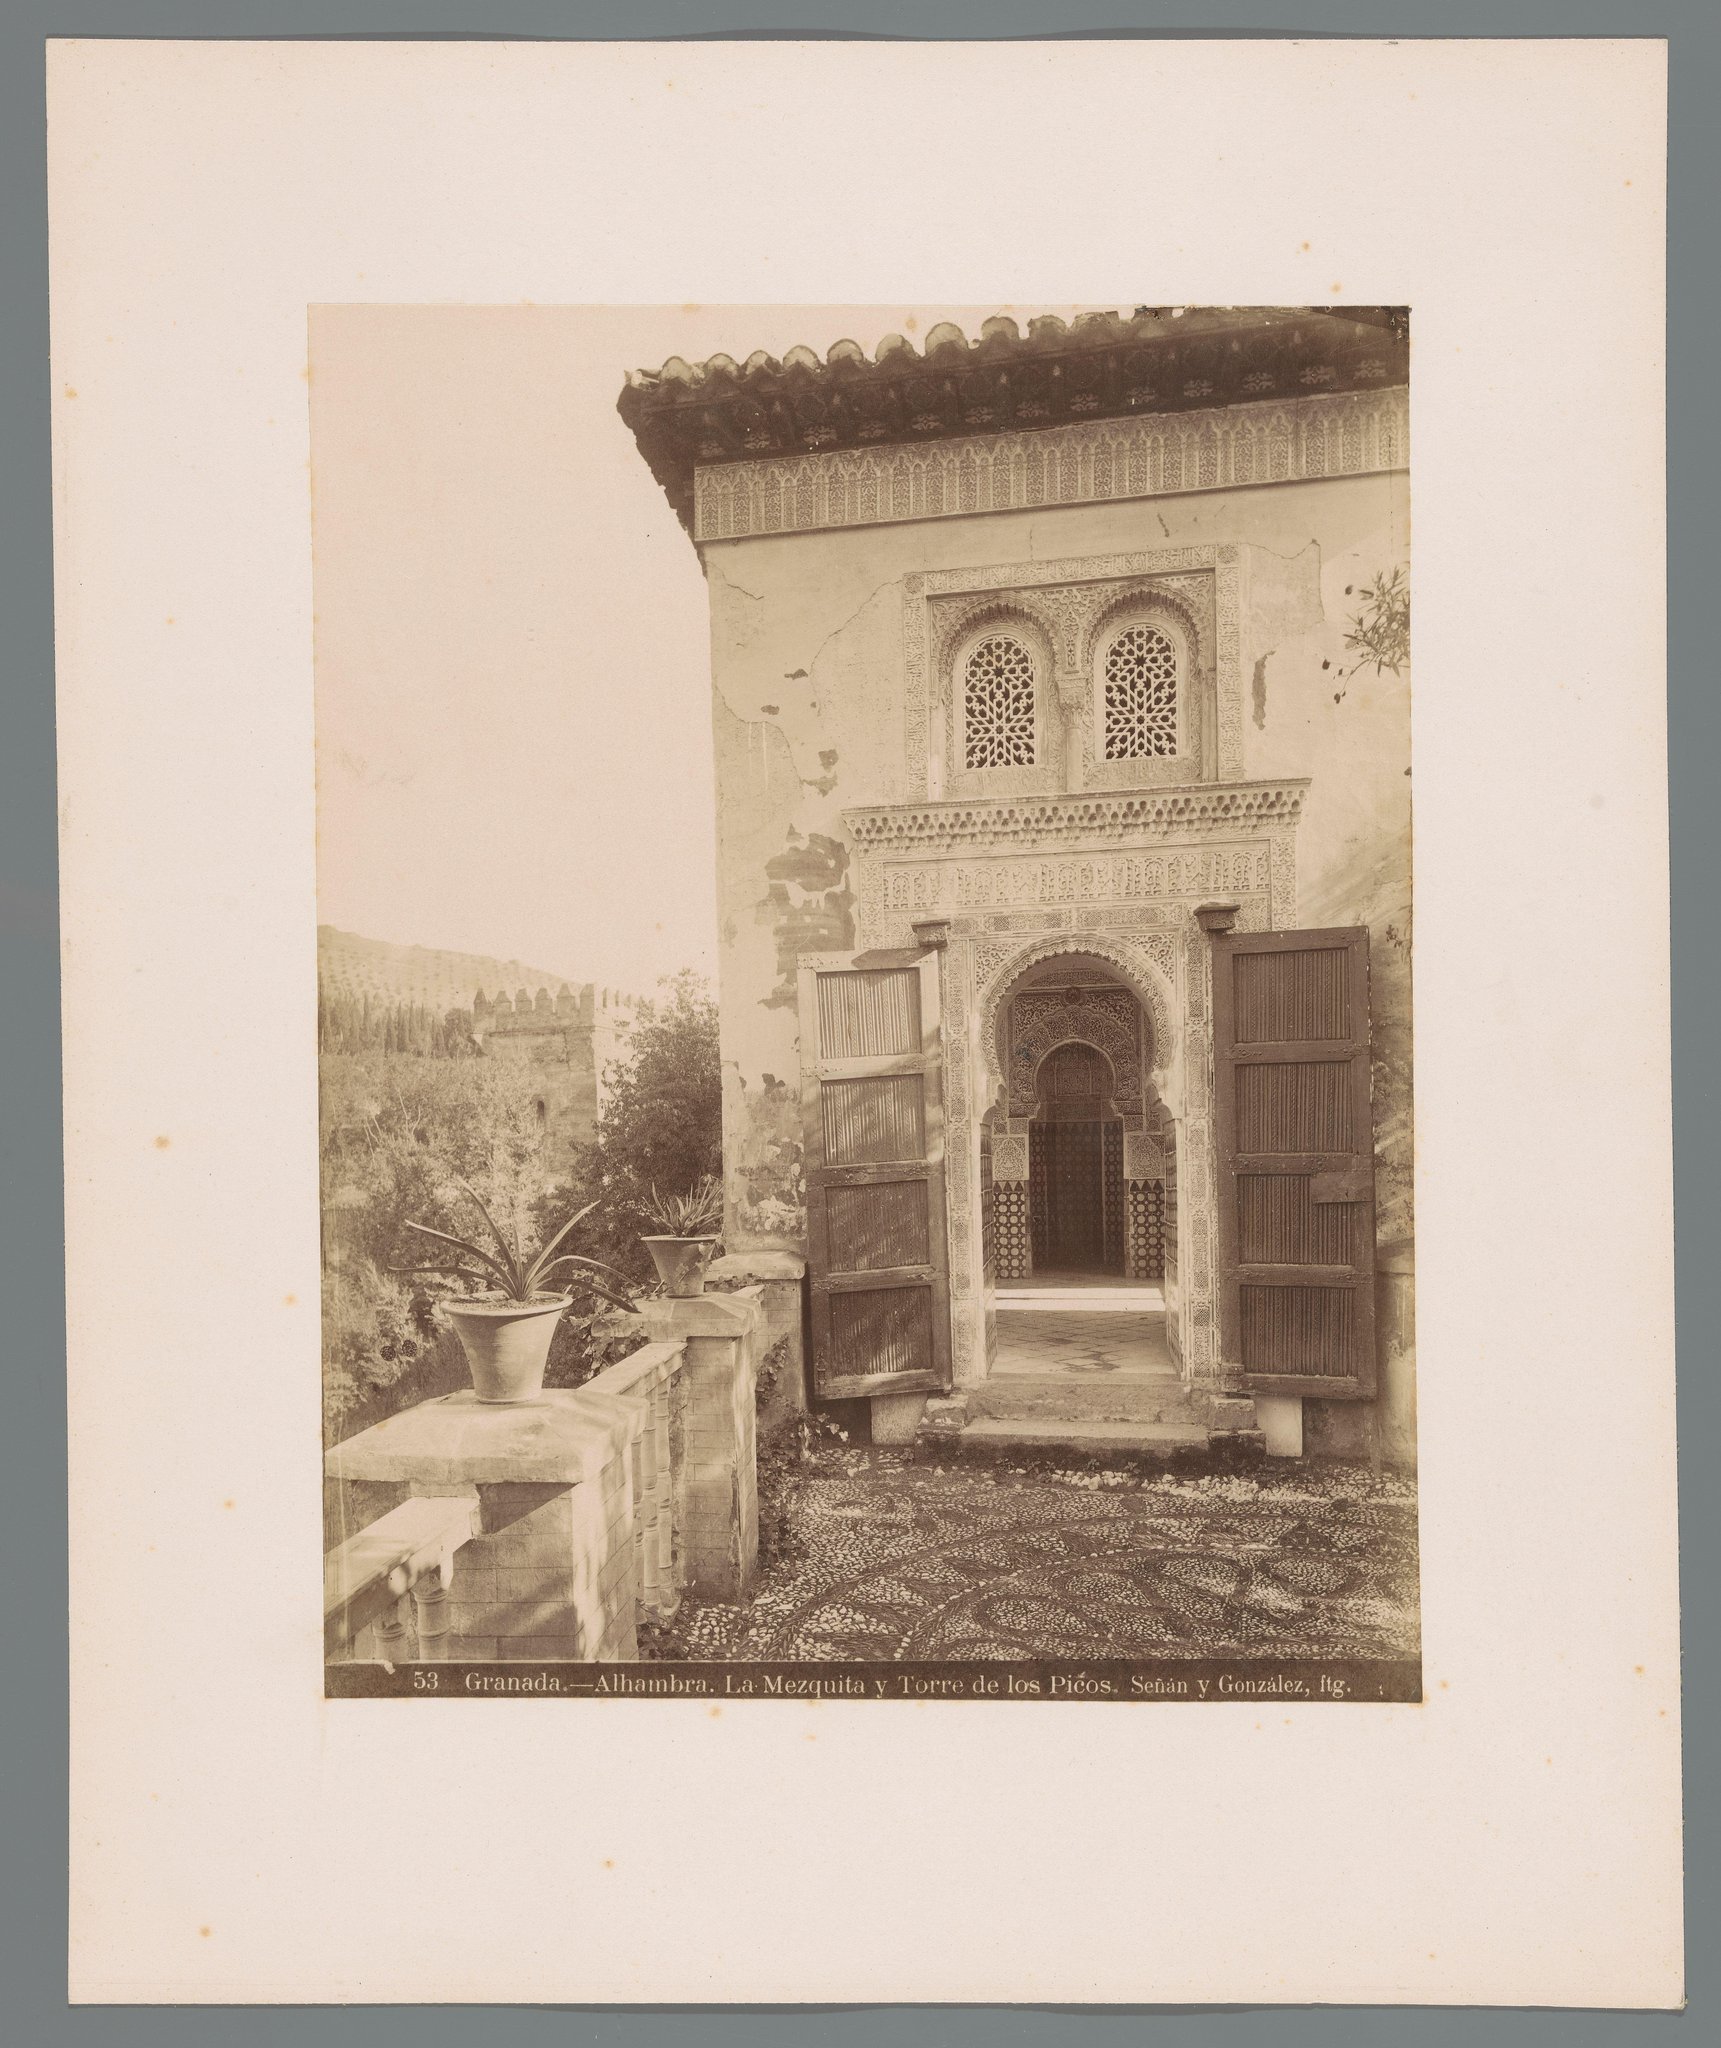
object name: photograph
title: Granada, Alhambra, La Mezquita y Torre de los Picos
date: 1880-1900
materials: cardboard, paper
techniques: albumen print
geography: granada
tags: towers ~ fortified city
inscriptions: number: ‘53’